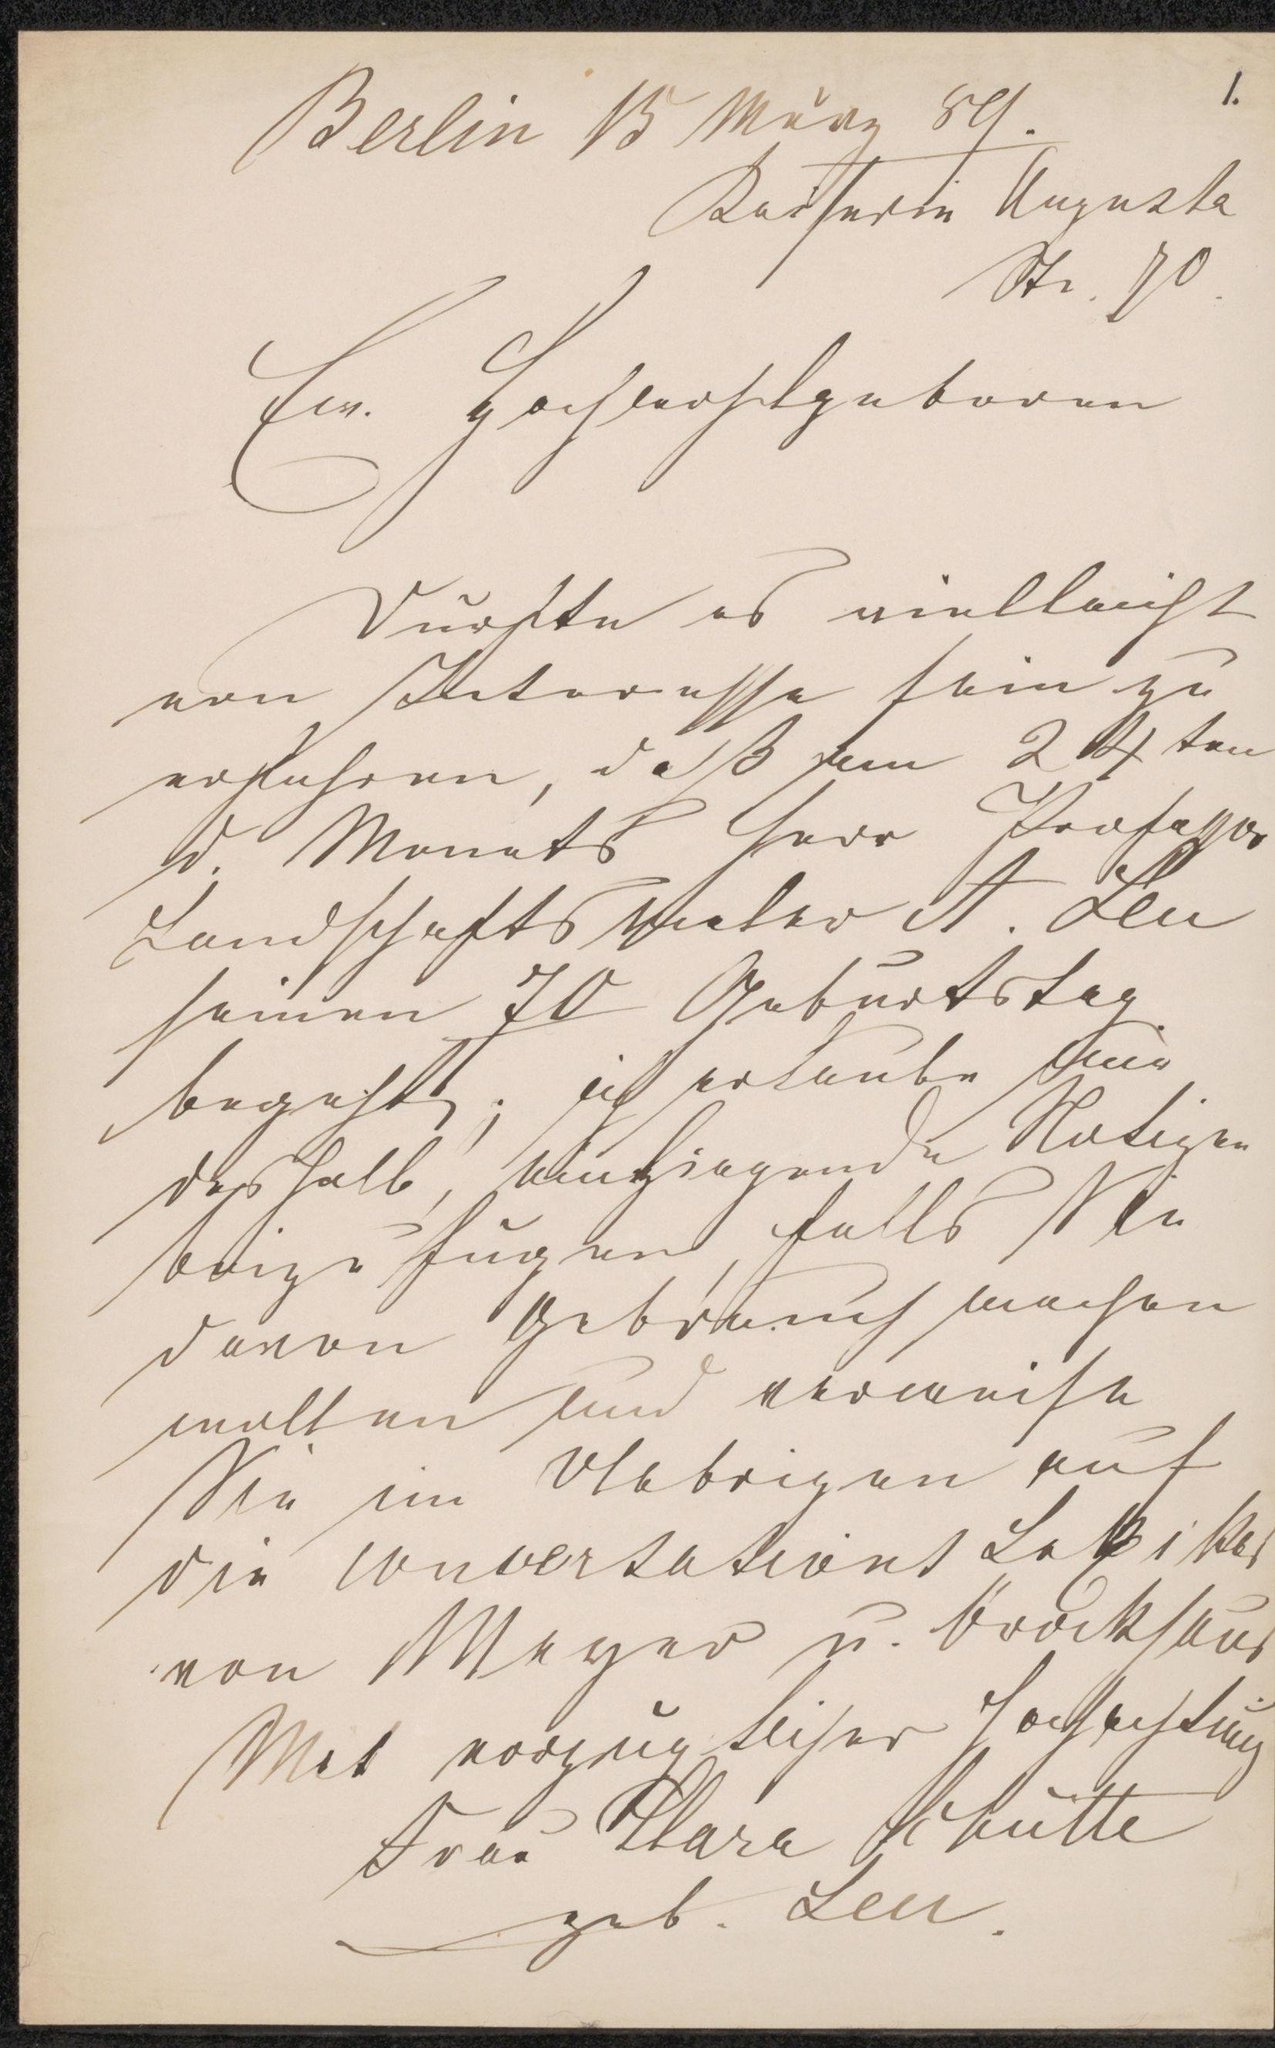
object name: letter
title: Brief aan Pieter Haverkorn van Rijsewijk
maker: clara leu-schütte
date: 1889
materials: ink, paper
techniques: pen, writing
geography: berlin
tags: pieter haverkorn van rijsewijk, distribution of awards ~ art contest, painting (including book-illumination, miniature-painting), art collecting